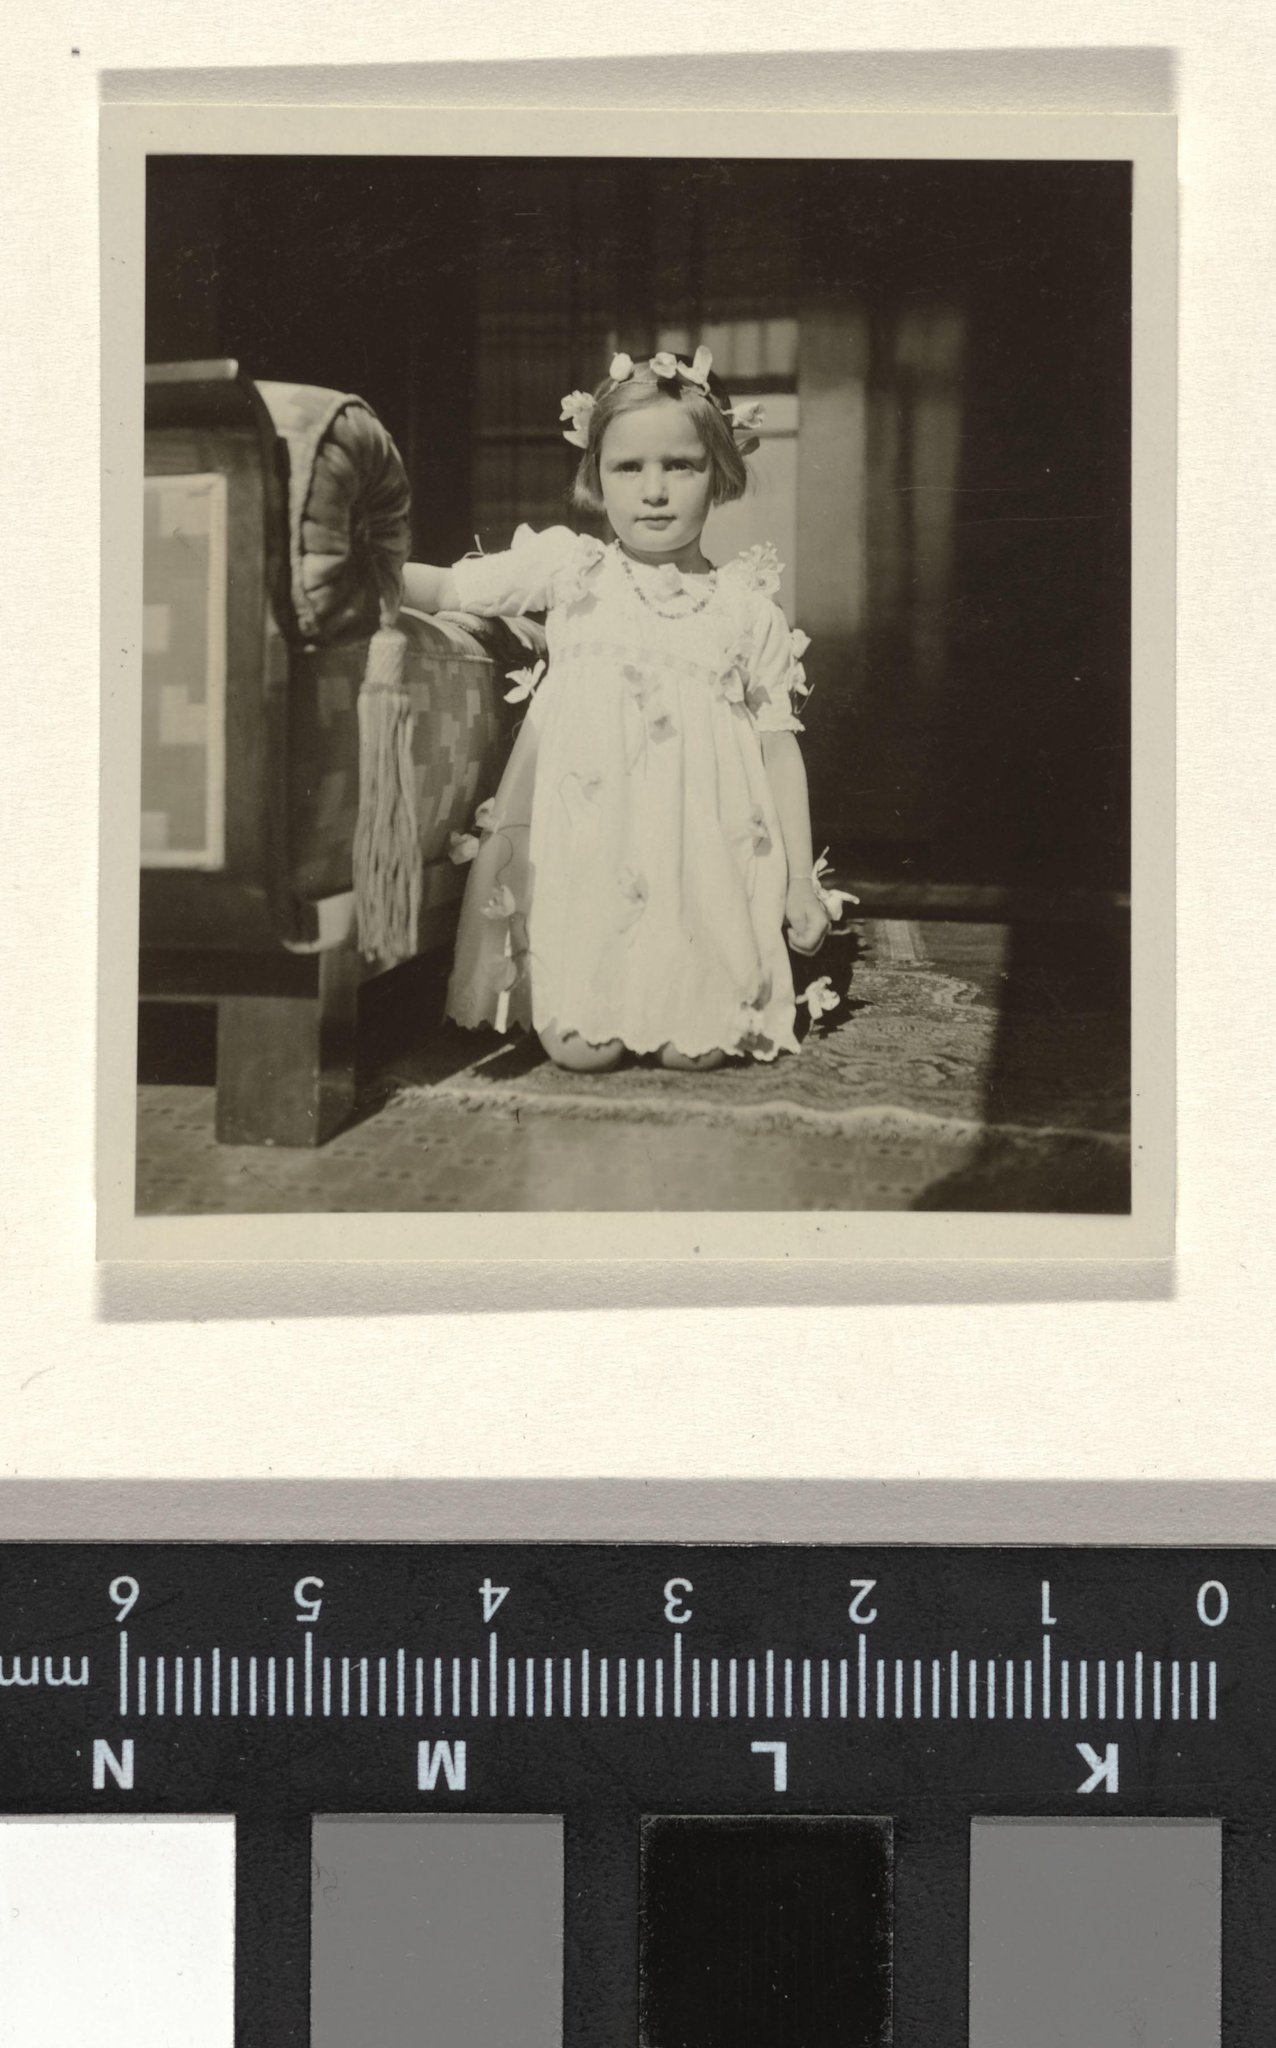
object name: photograph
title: Isabel Wachenheimer met bloemenkrans en bloemenketting, knielend bij een bank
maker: Anonymous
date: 1903-1932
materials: photographic support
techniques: gelatin silver print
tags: isabel wachenheimer-elon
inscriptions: number: ‘21’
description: Isabel Wachenheimer met bloemenkrans en bloemenketting, knielend bij een bank